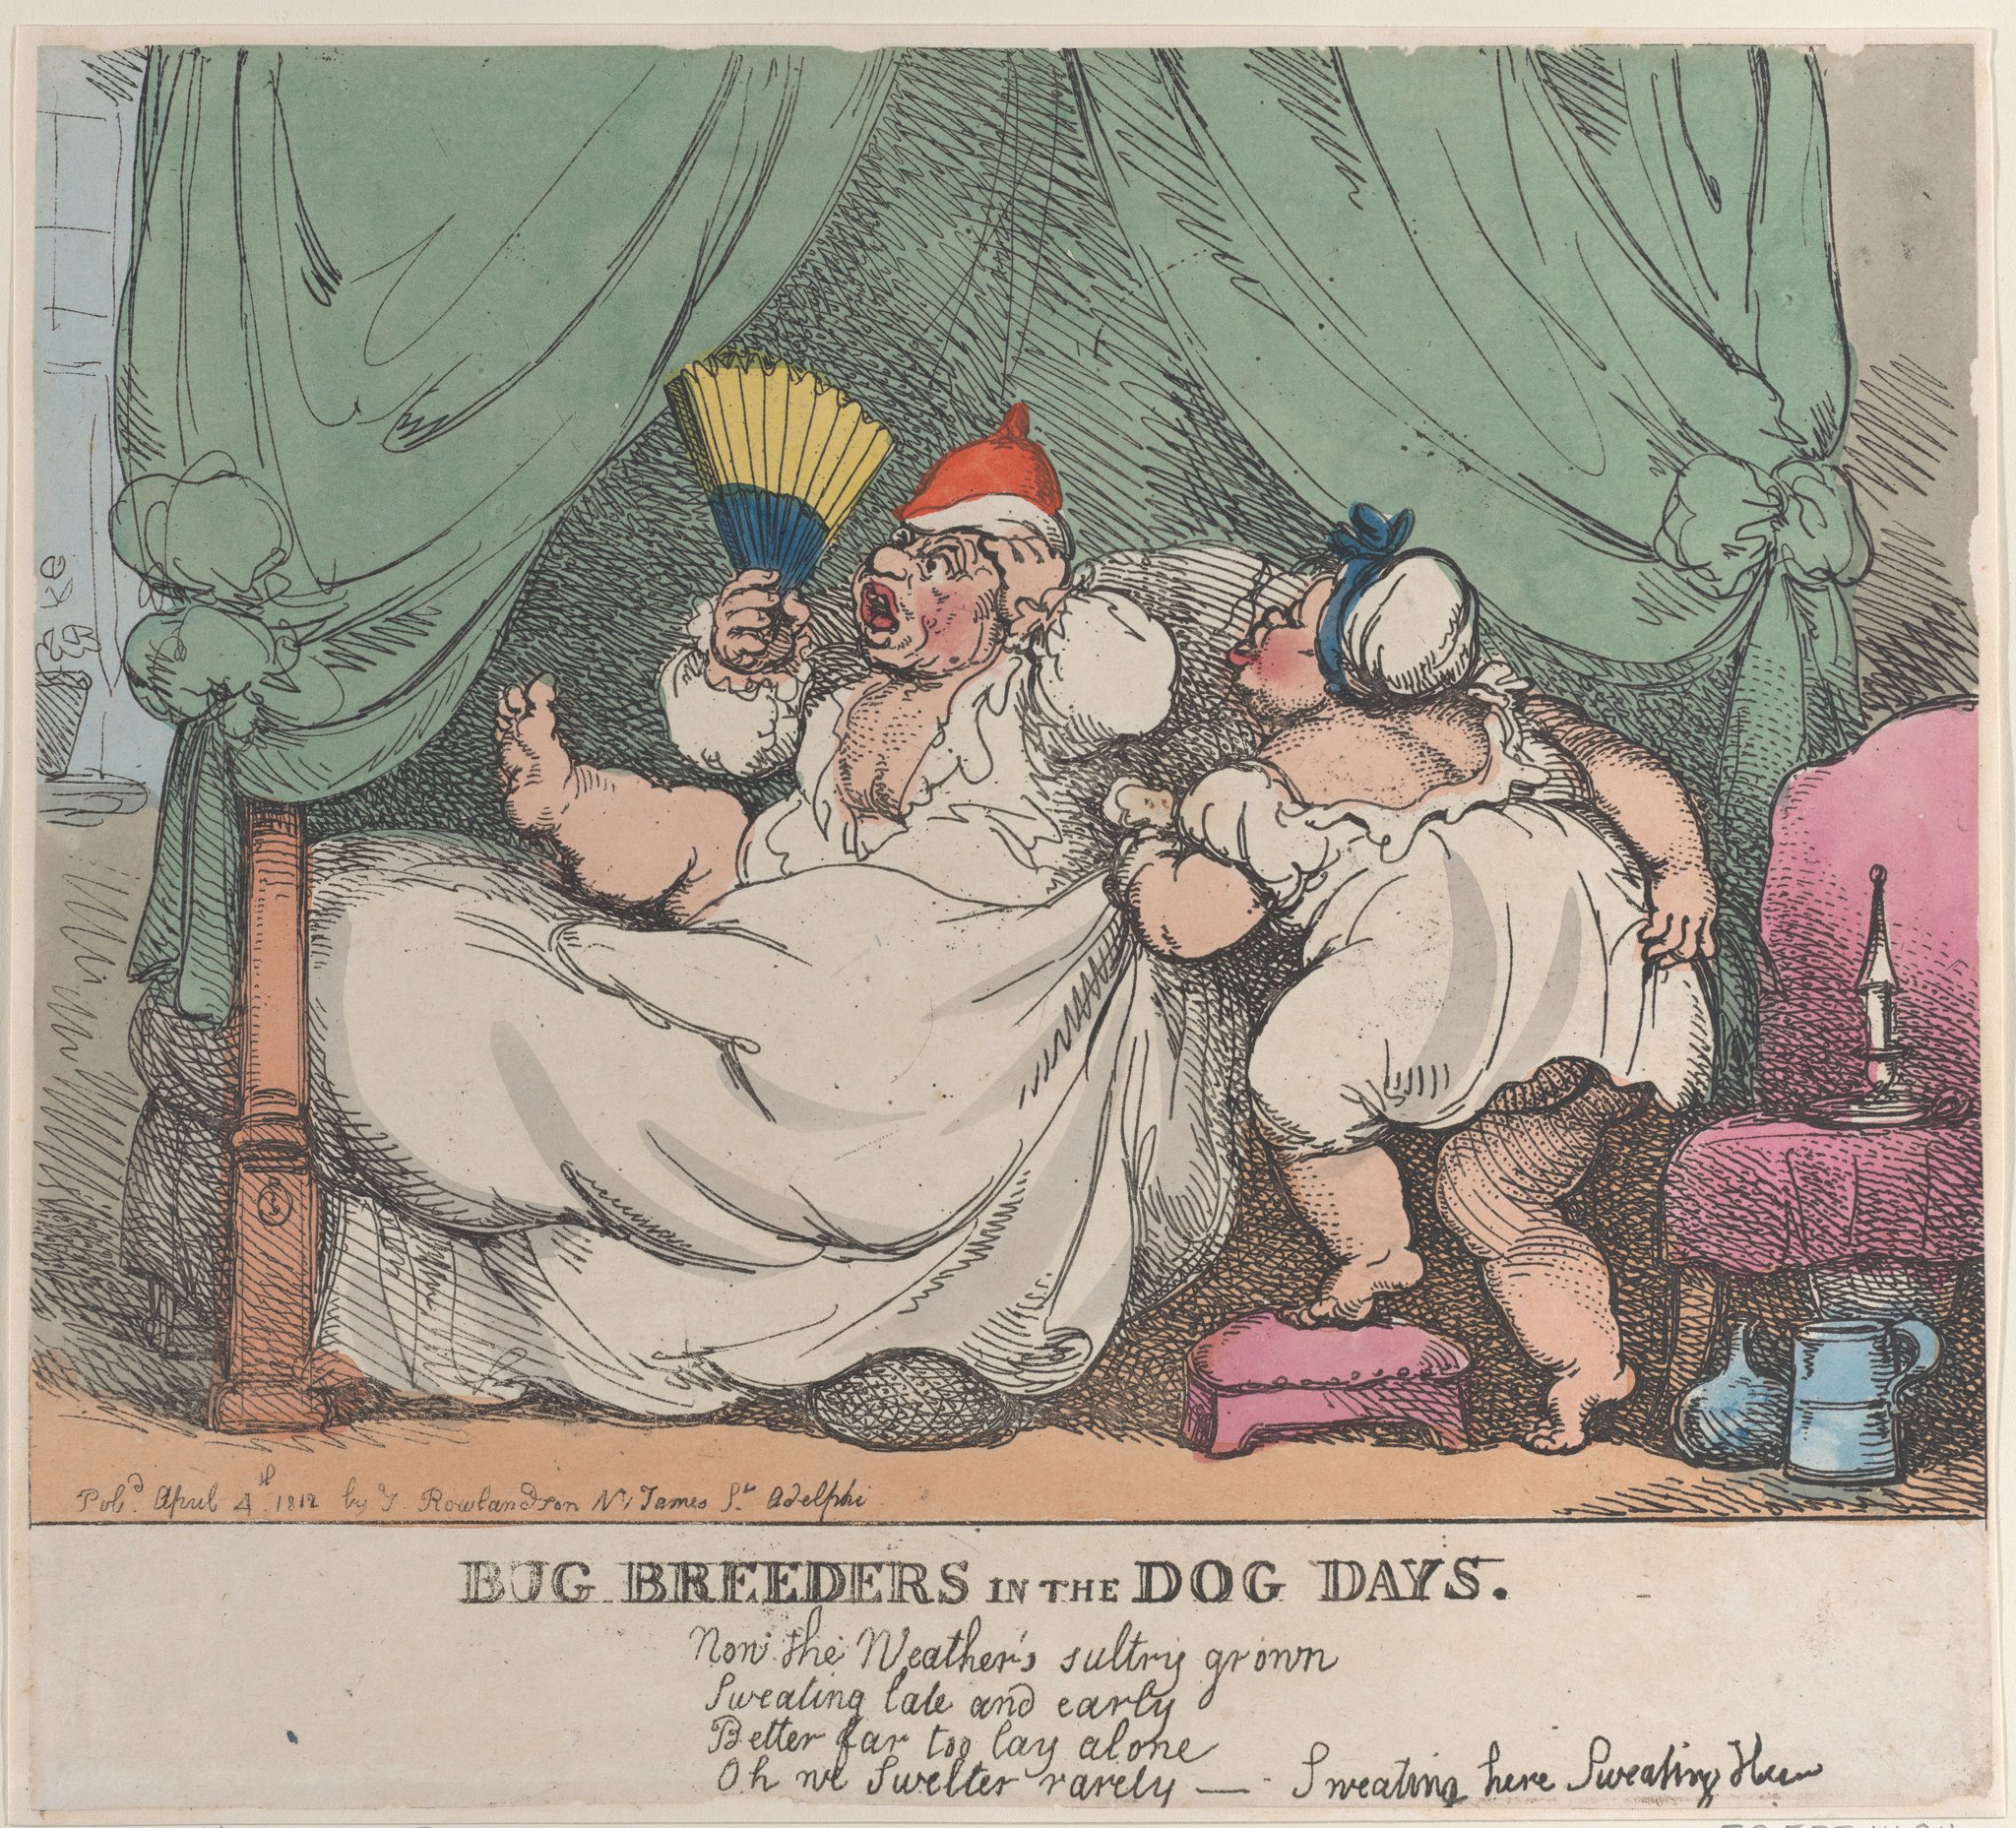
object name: print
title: Bug Breeders in the Dog Days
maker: thomas rowlandson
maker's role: artist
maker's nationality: british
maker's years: 1757-1827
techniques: etching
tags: bedrooms,men,women,caricature